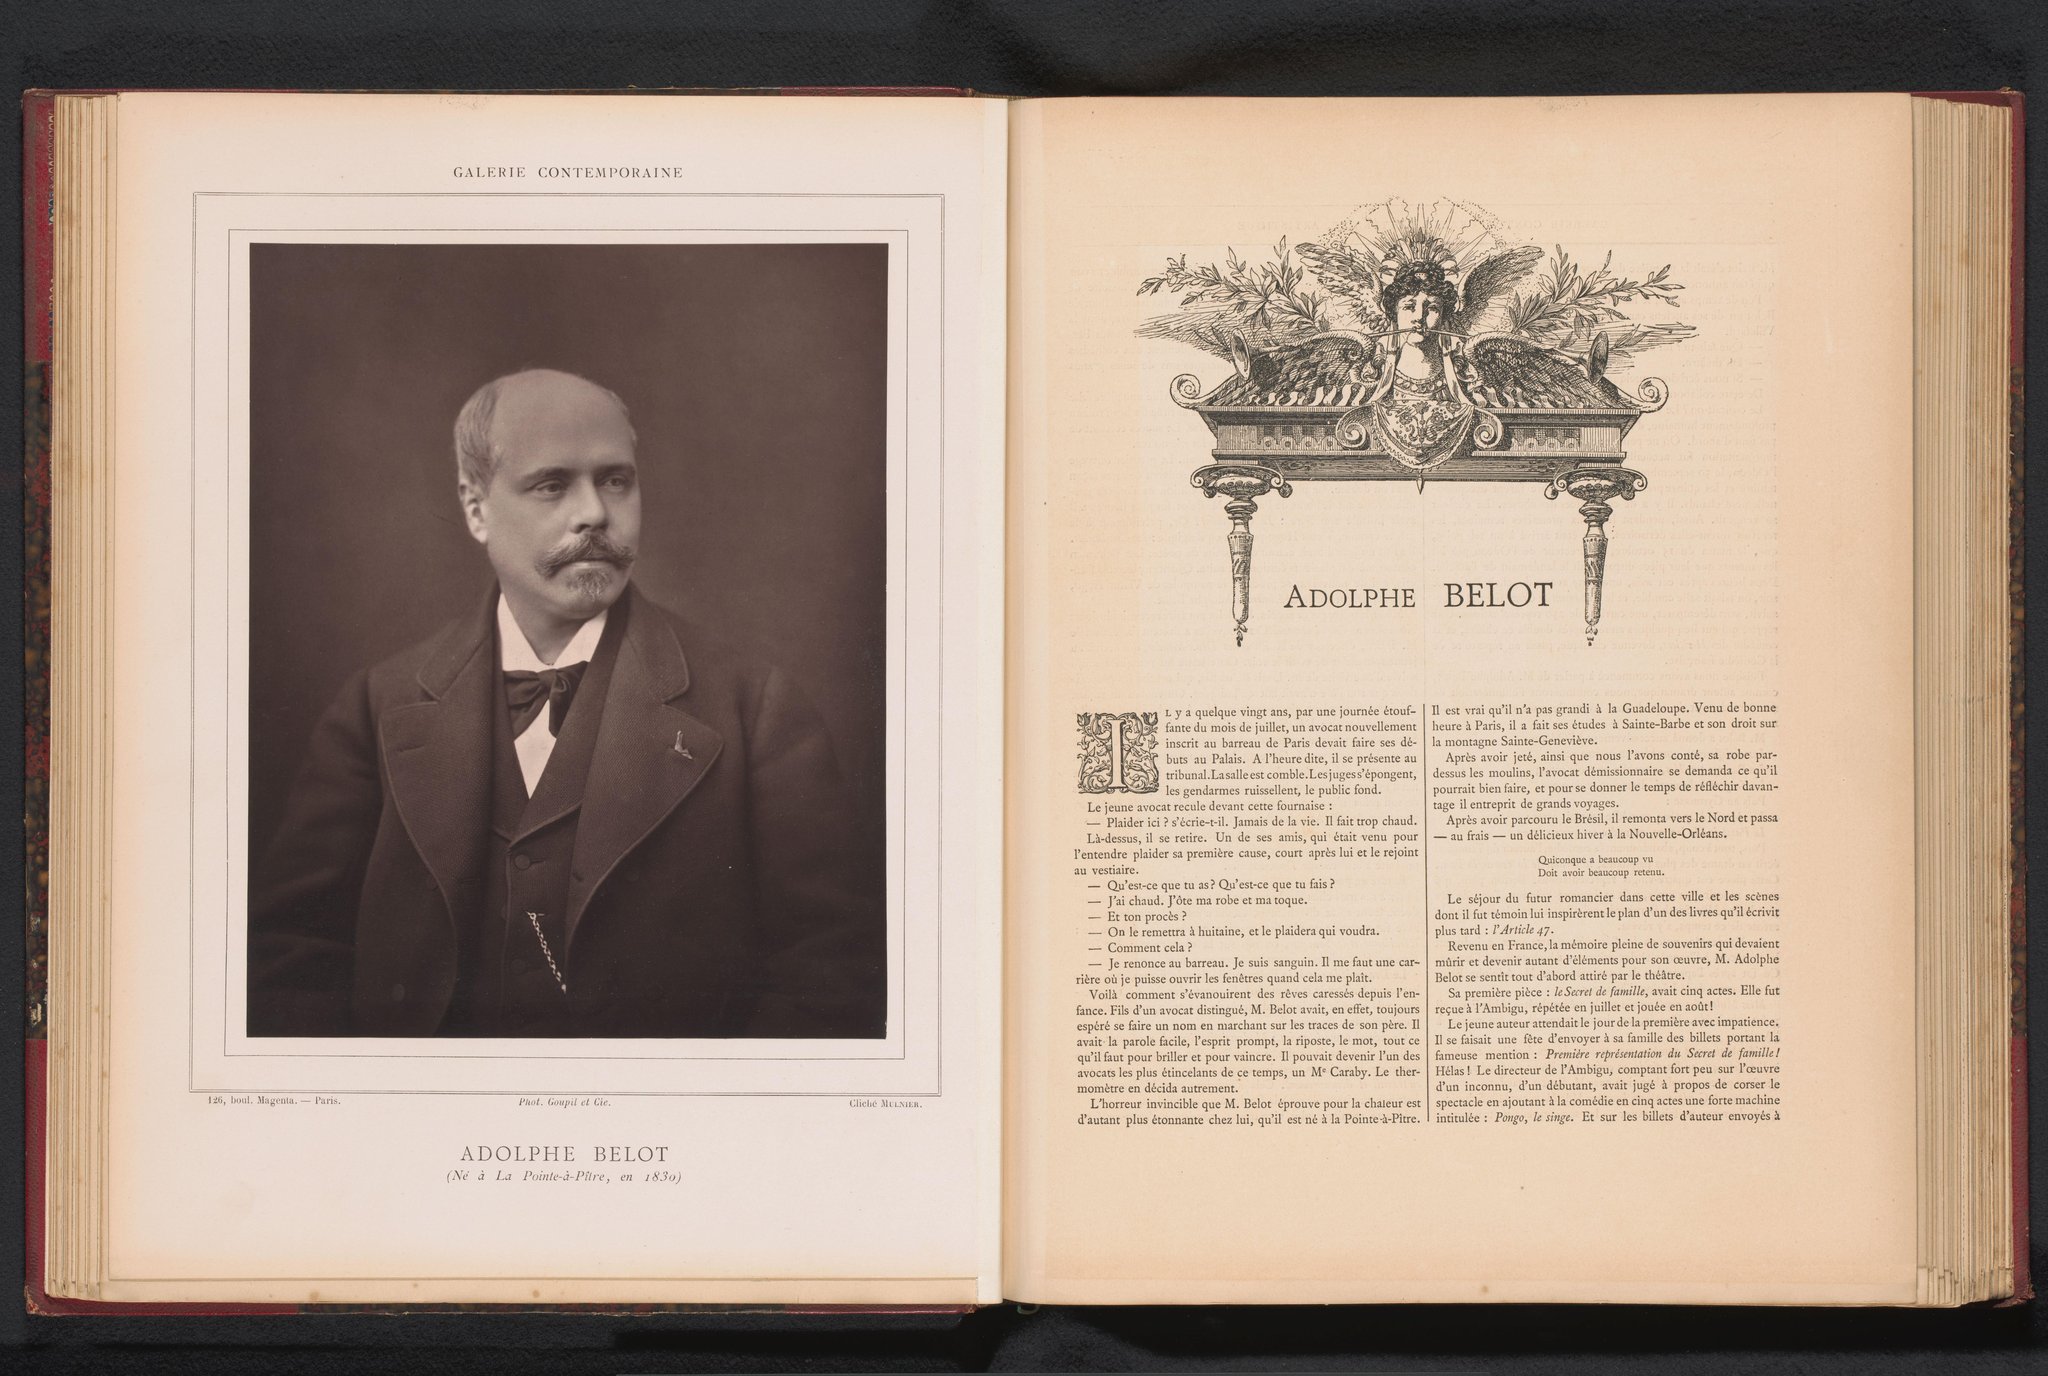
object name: photomechanical print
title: Adolphe Belot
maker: ferdinand mulnier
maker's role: painter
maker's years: 1817-1891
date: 1874-1879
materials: paper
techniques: woodburytype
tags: adult man, historical persons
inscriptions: inscription: ‘Galerie Contemporaine/ 126, boul. Magenta. - Paris./ (Né a La Pointe-a-Pître, en 1830)’